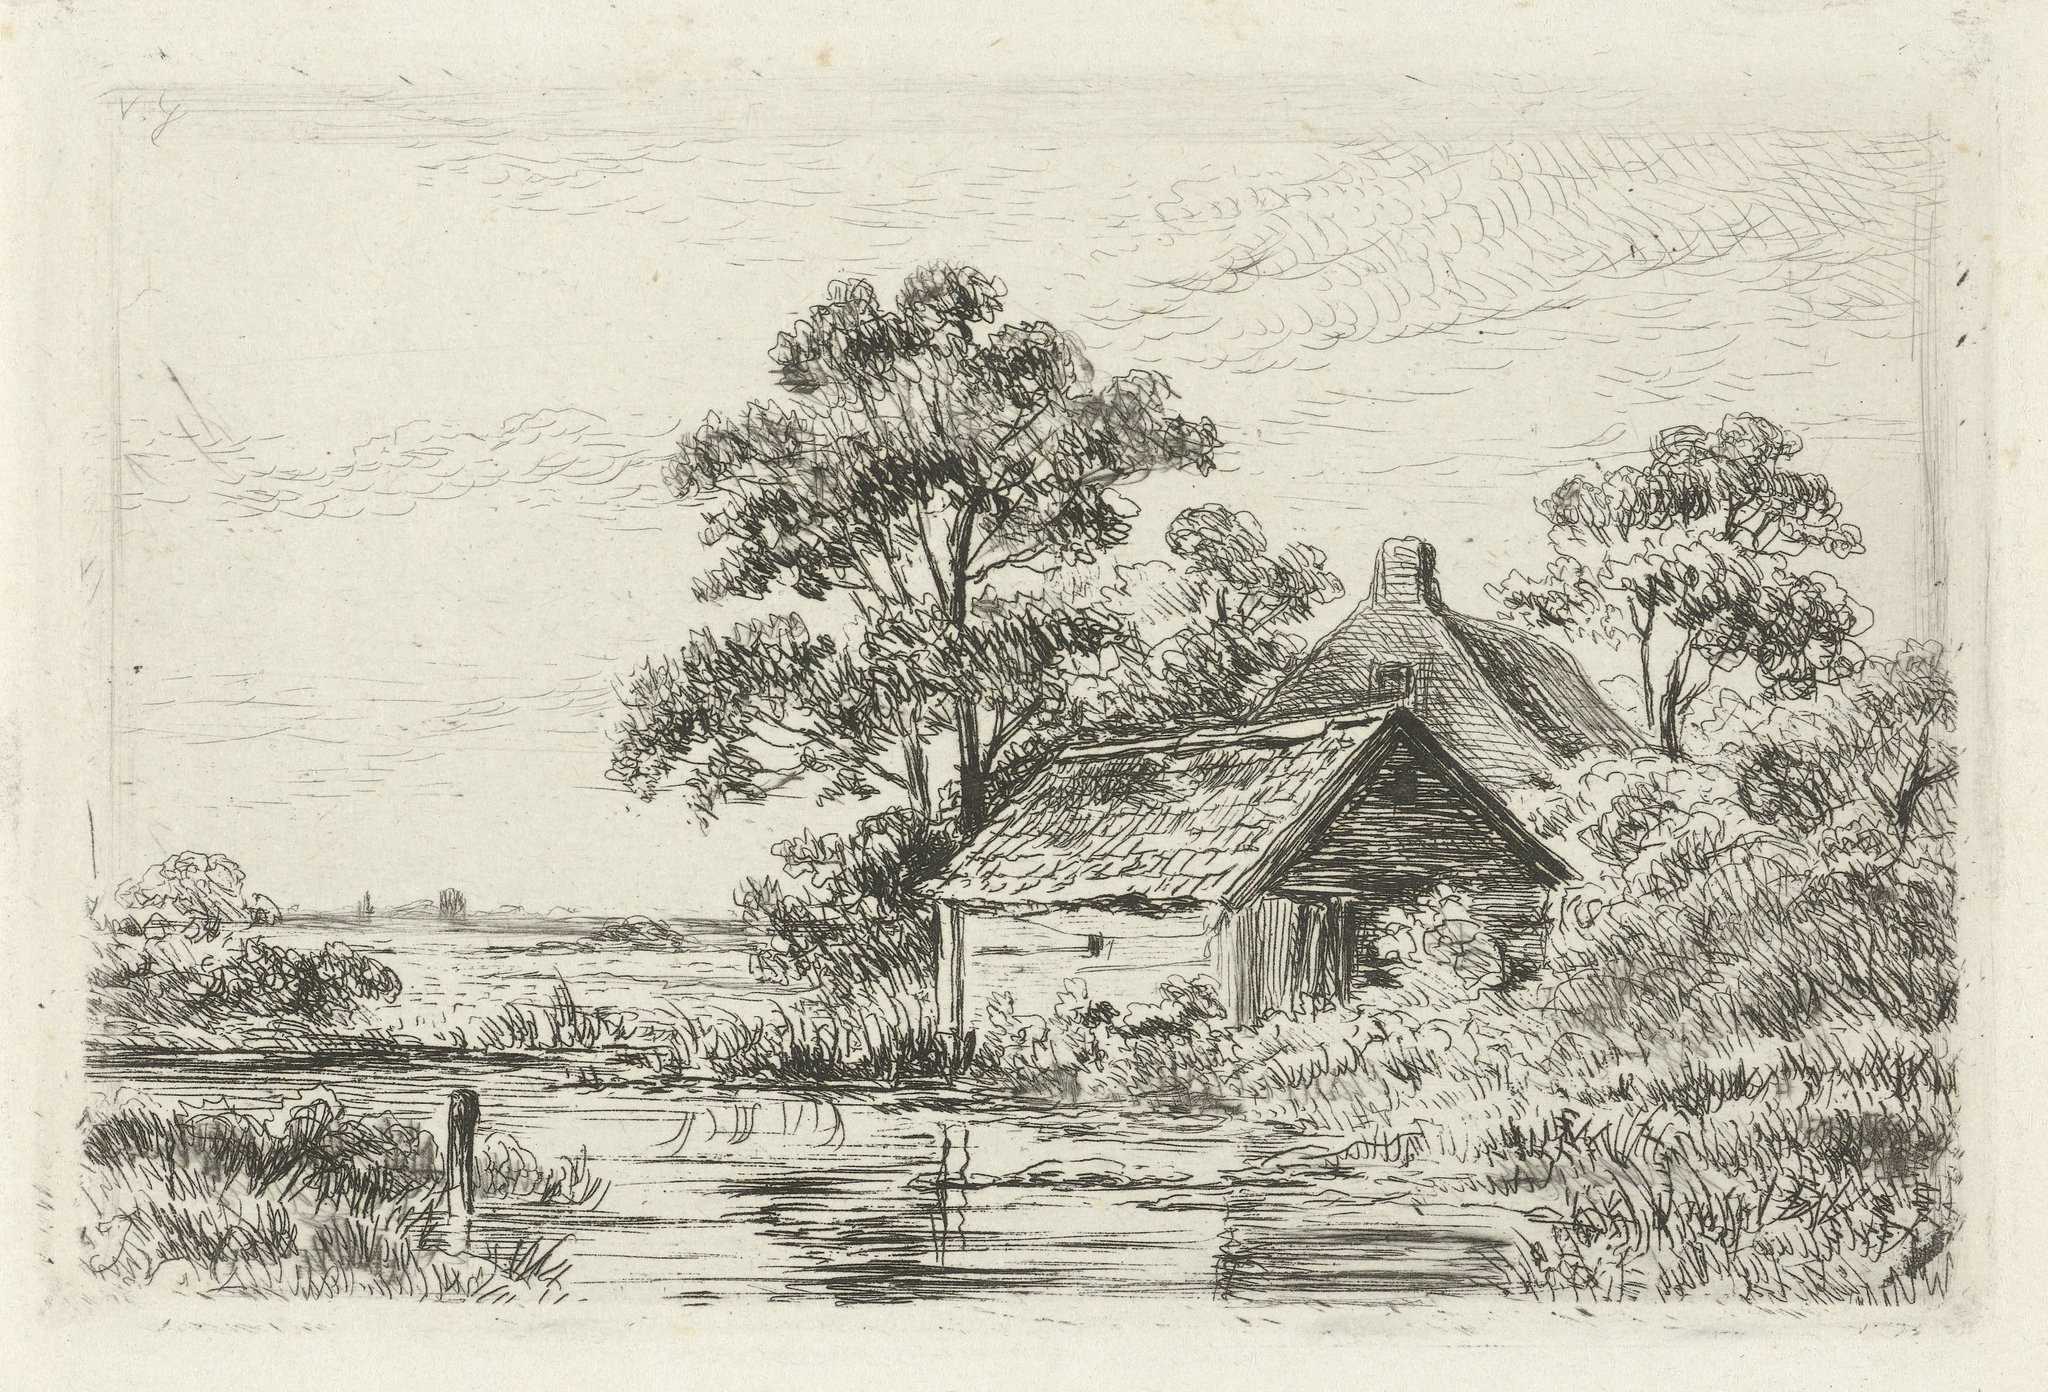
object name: print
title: Landschap met boerenwoning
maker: jacques van gingelen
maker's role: print maker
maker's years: 1801-1864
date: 1810-1864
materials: paper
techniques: etching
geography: borgerhout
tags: river, farm or solitary house in landscape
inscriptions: collector's mark: Lugt 2228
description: Landschap met boerenwoning. Op de voorgrond een rivier.